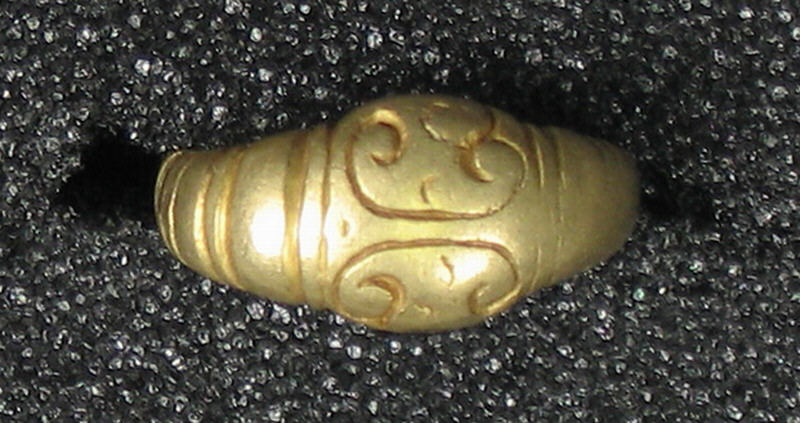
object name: ring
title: Ring with Incised C-Scrolls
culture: indonesian, central java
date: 701-1200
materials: gold